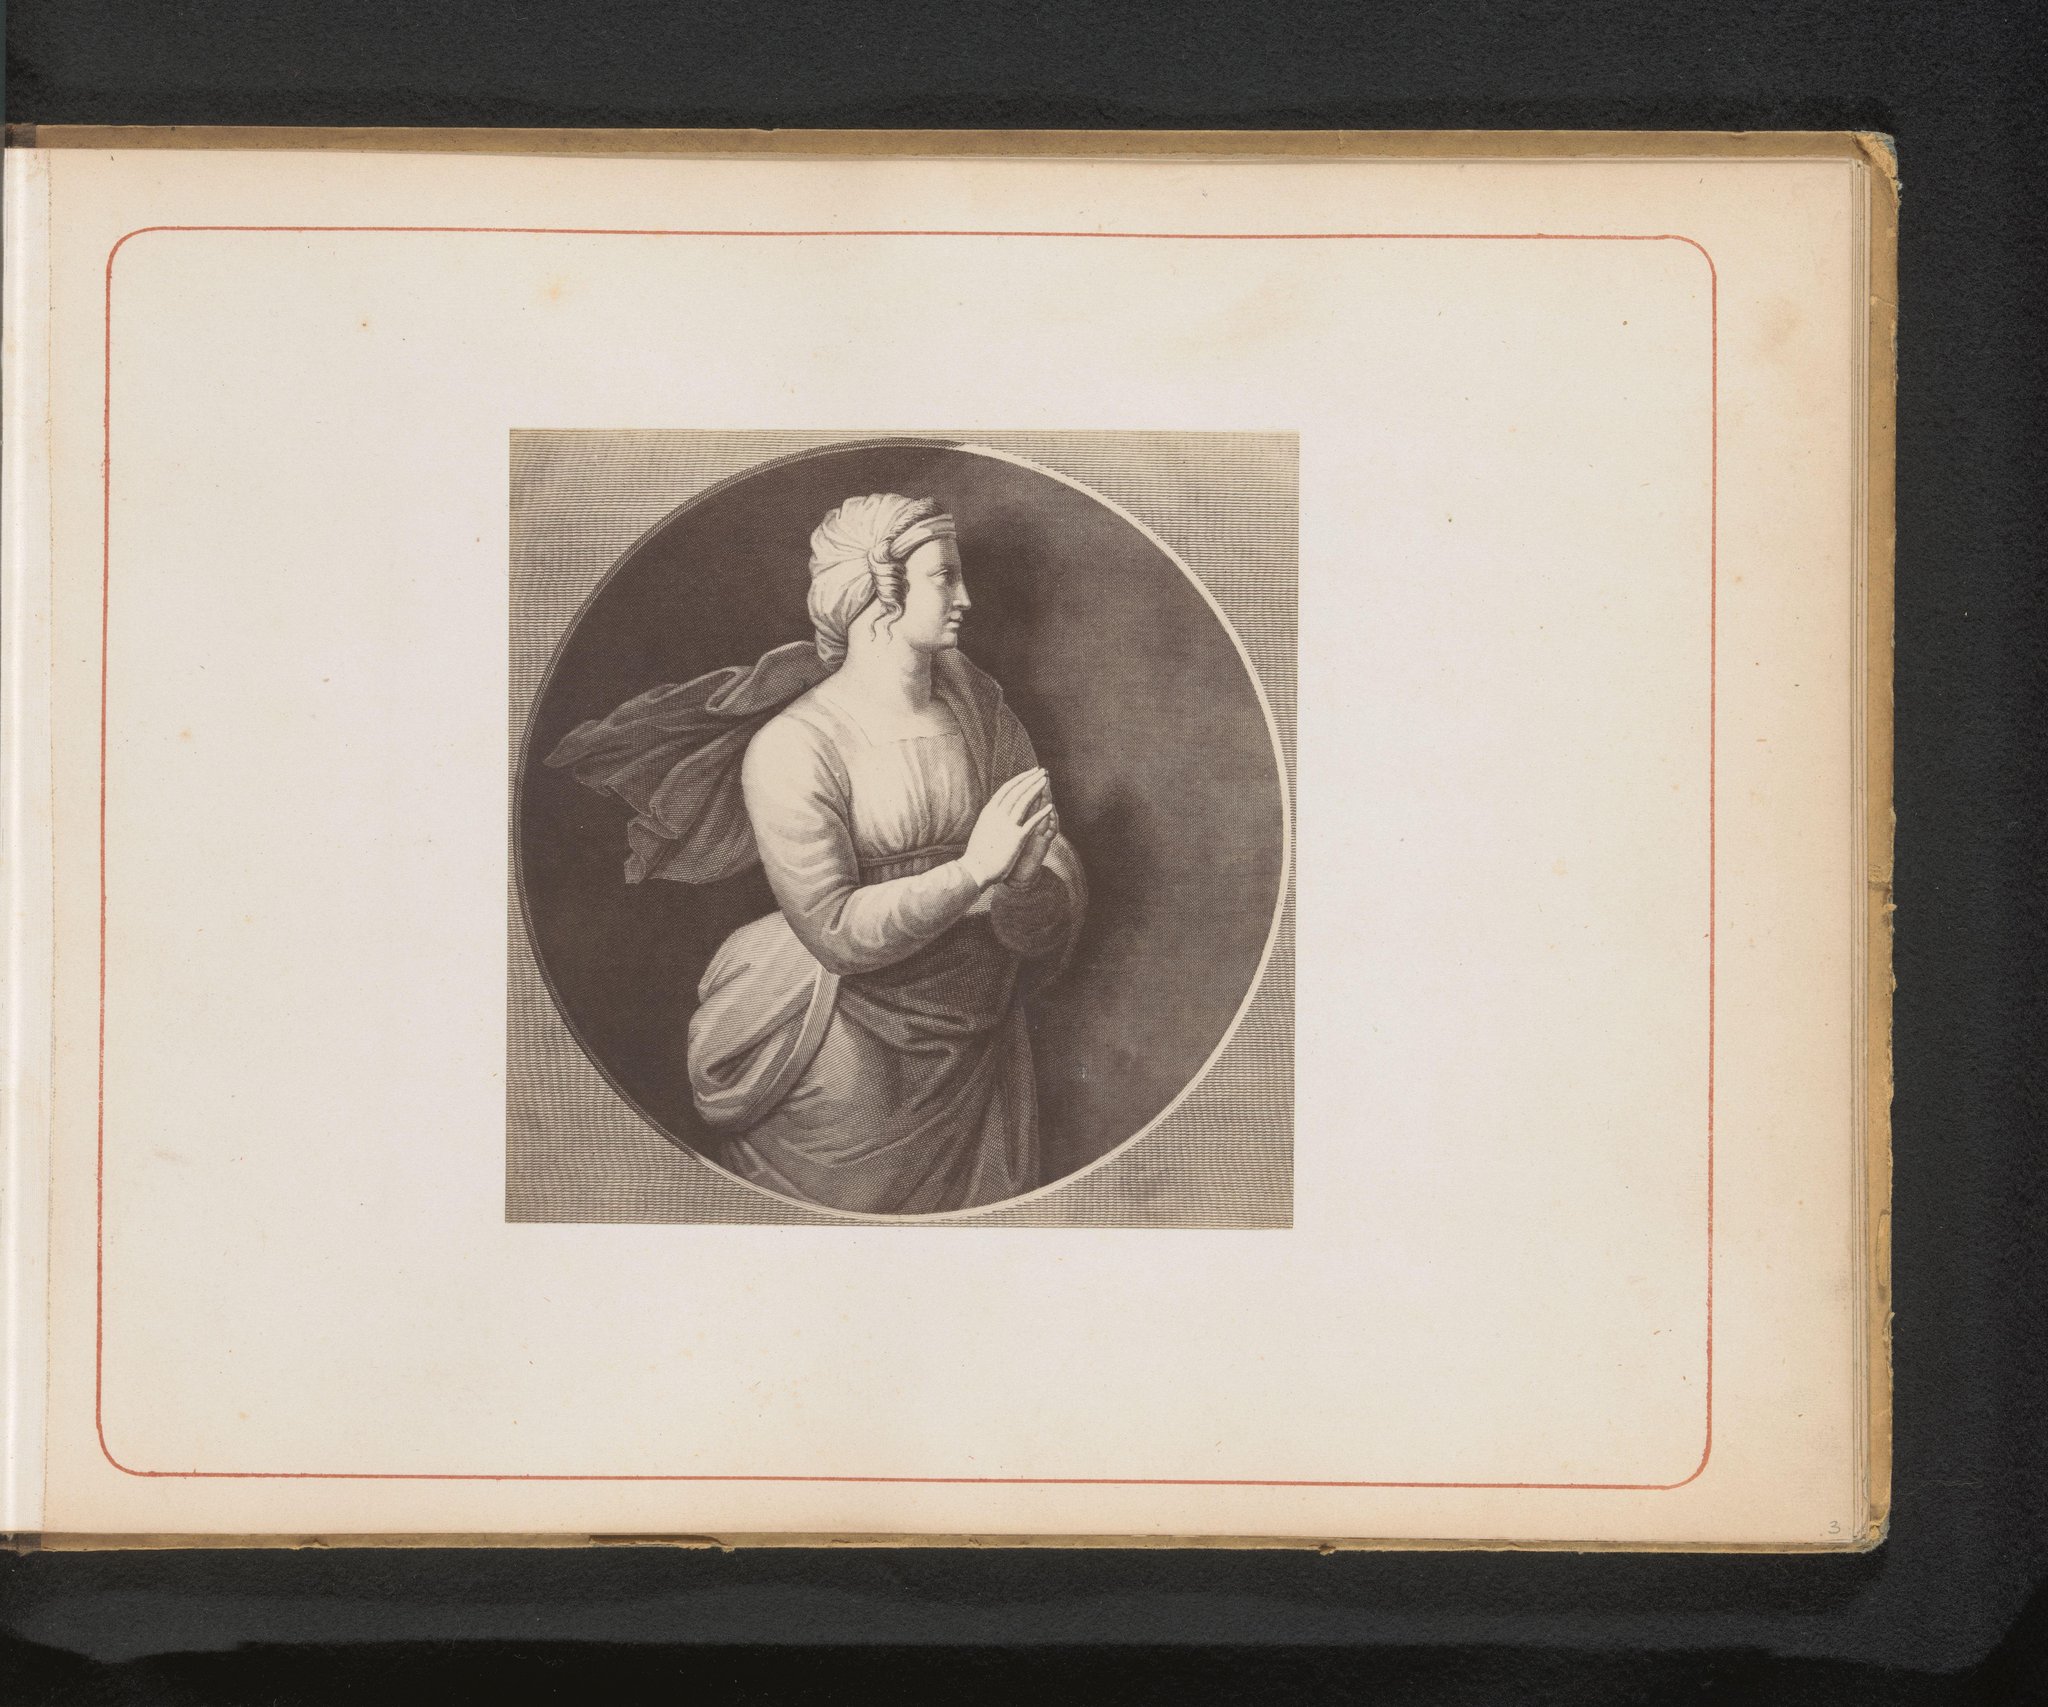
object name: page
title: Fotoreproductie van een gravure naar Hoop door Rafaël in het Vaticaan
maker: Anonymous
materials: photographic support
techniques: albumen print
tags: hope, 'spes'; 'speranza divina e certa' (ripa) ~ one of the three theological virtues